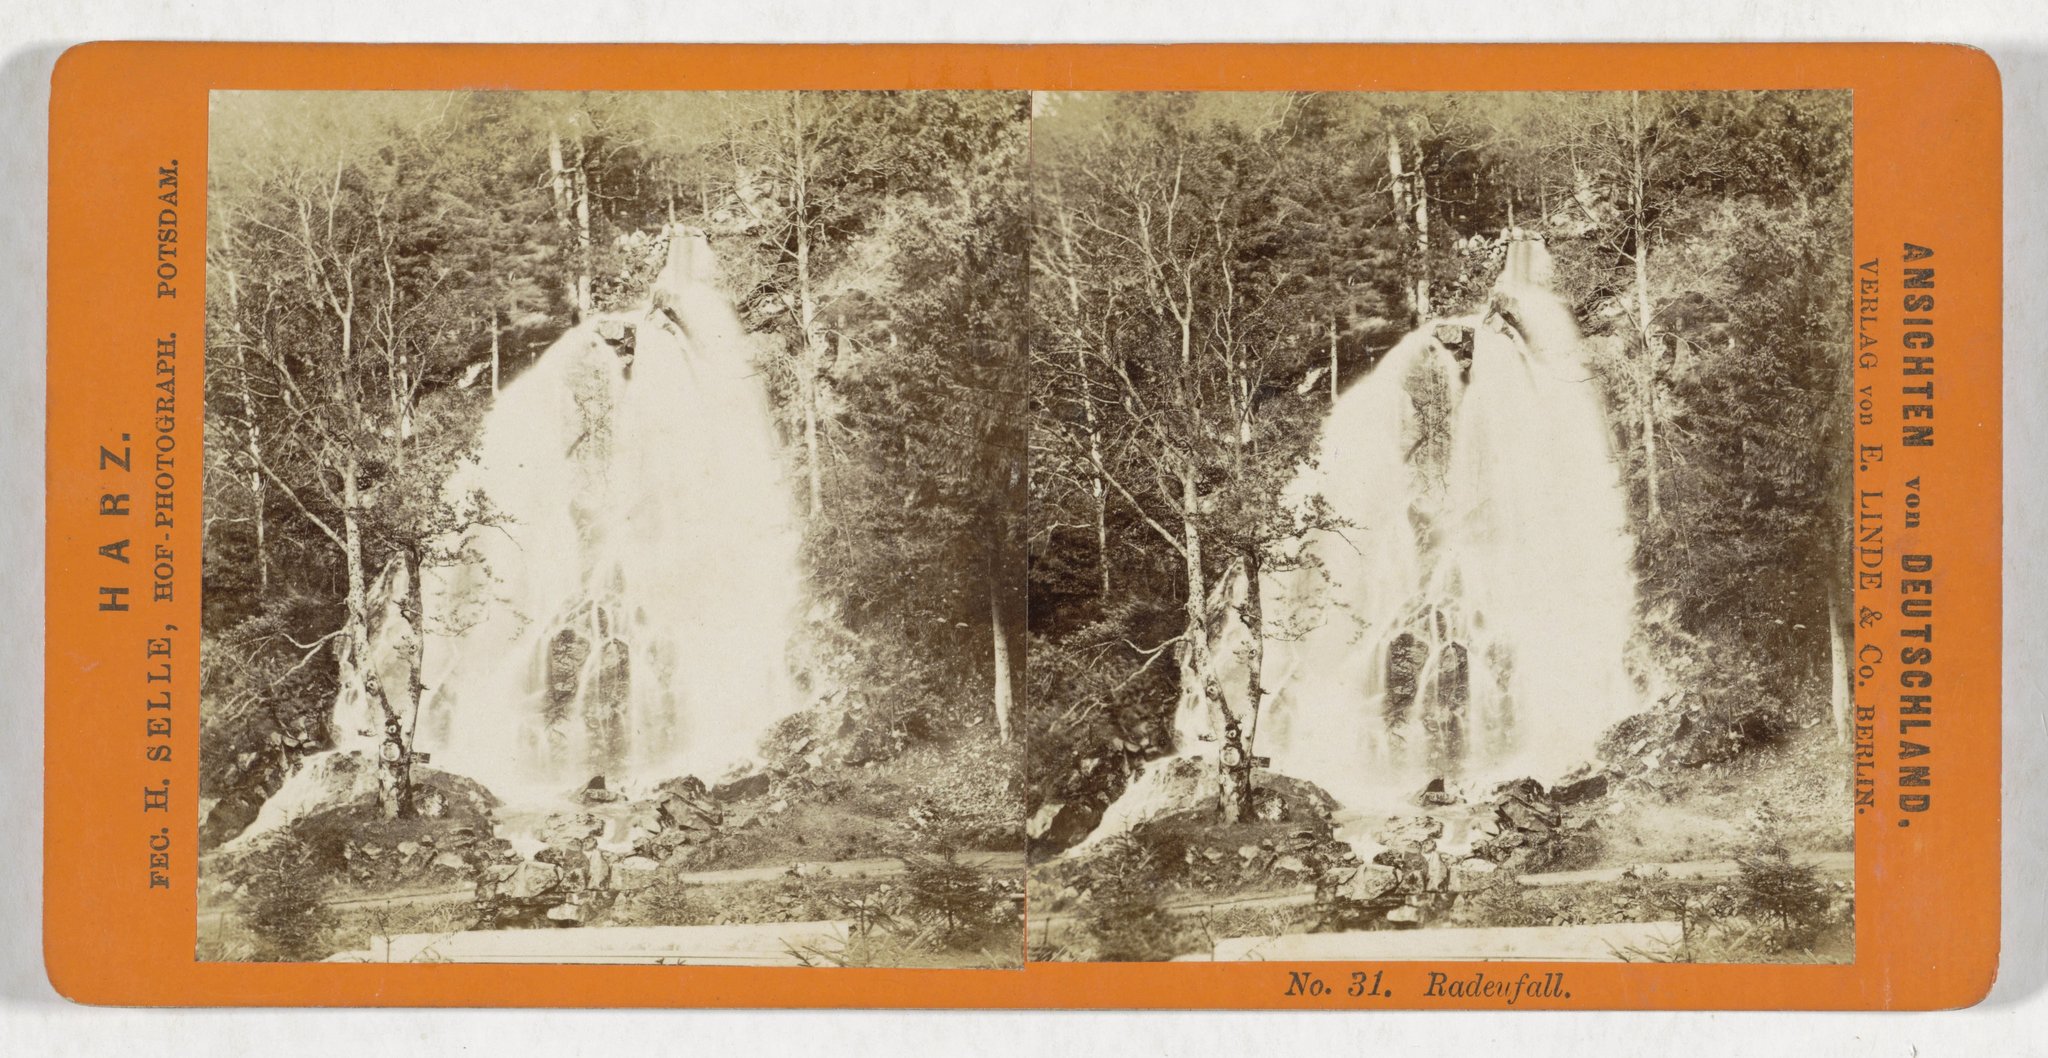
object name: stereograph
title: Waterval van de Radau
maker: hermann selle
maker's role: fotograaf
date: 1868-1890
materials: cardboard, paper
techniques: albumen print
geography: radauwasserfall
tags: waterfall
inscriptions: inscription: ‘Hof-Photograph. Potsdam.’, inscription: ‘No. 31. Harz. Radaufall/ Von Neustadt-Harzburg (...) besuchenswerth ist. (W.Riehl.)’, number: ‘No. 31’